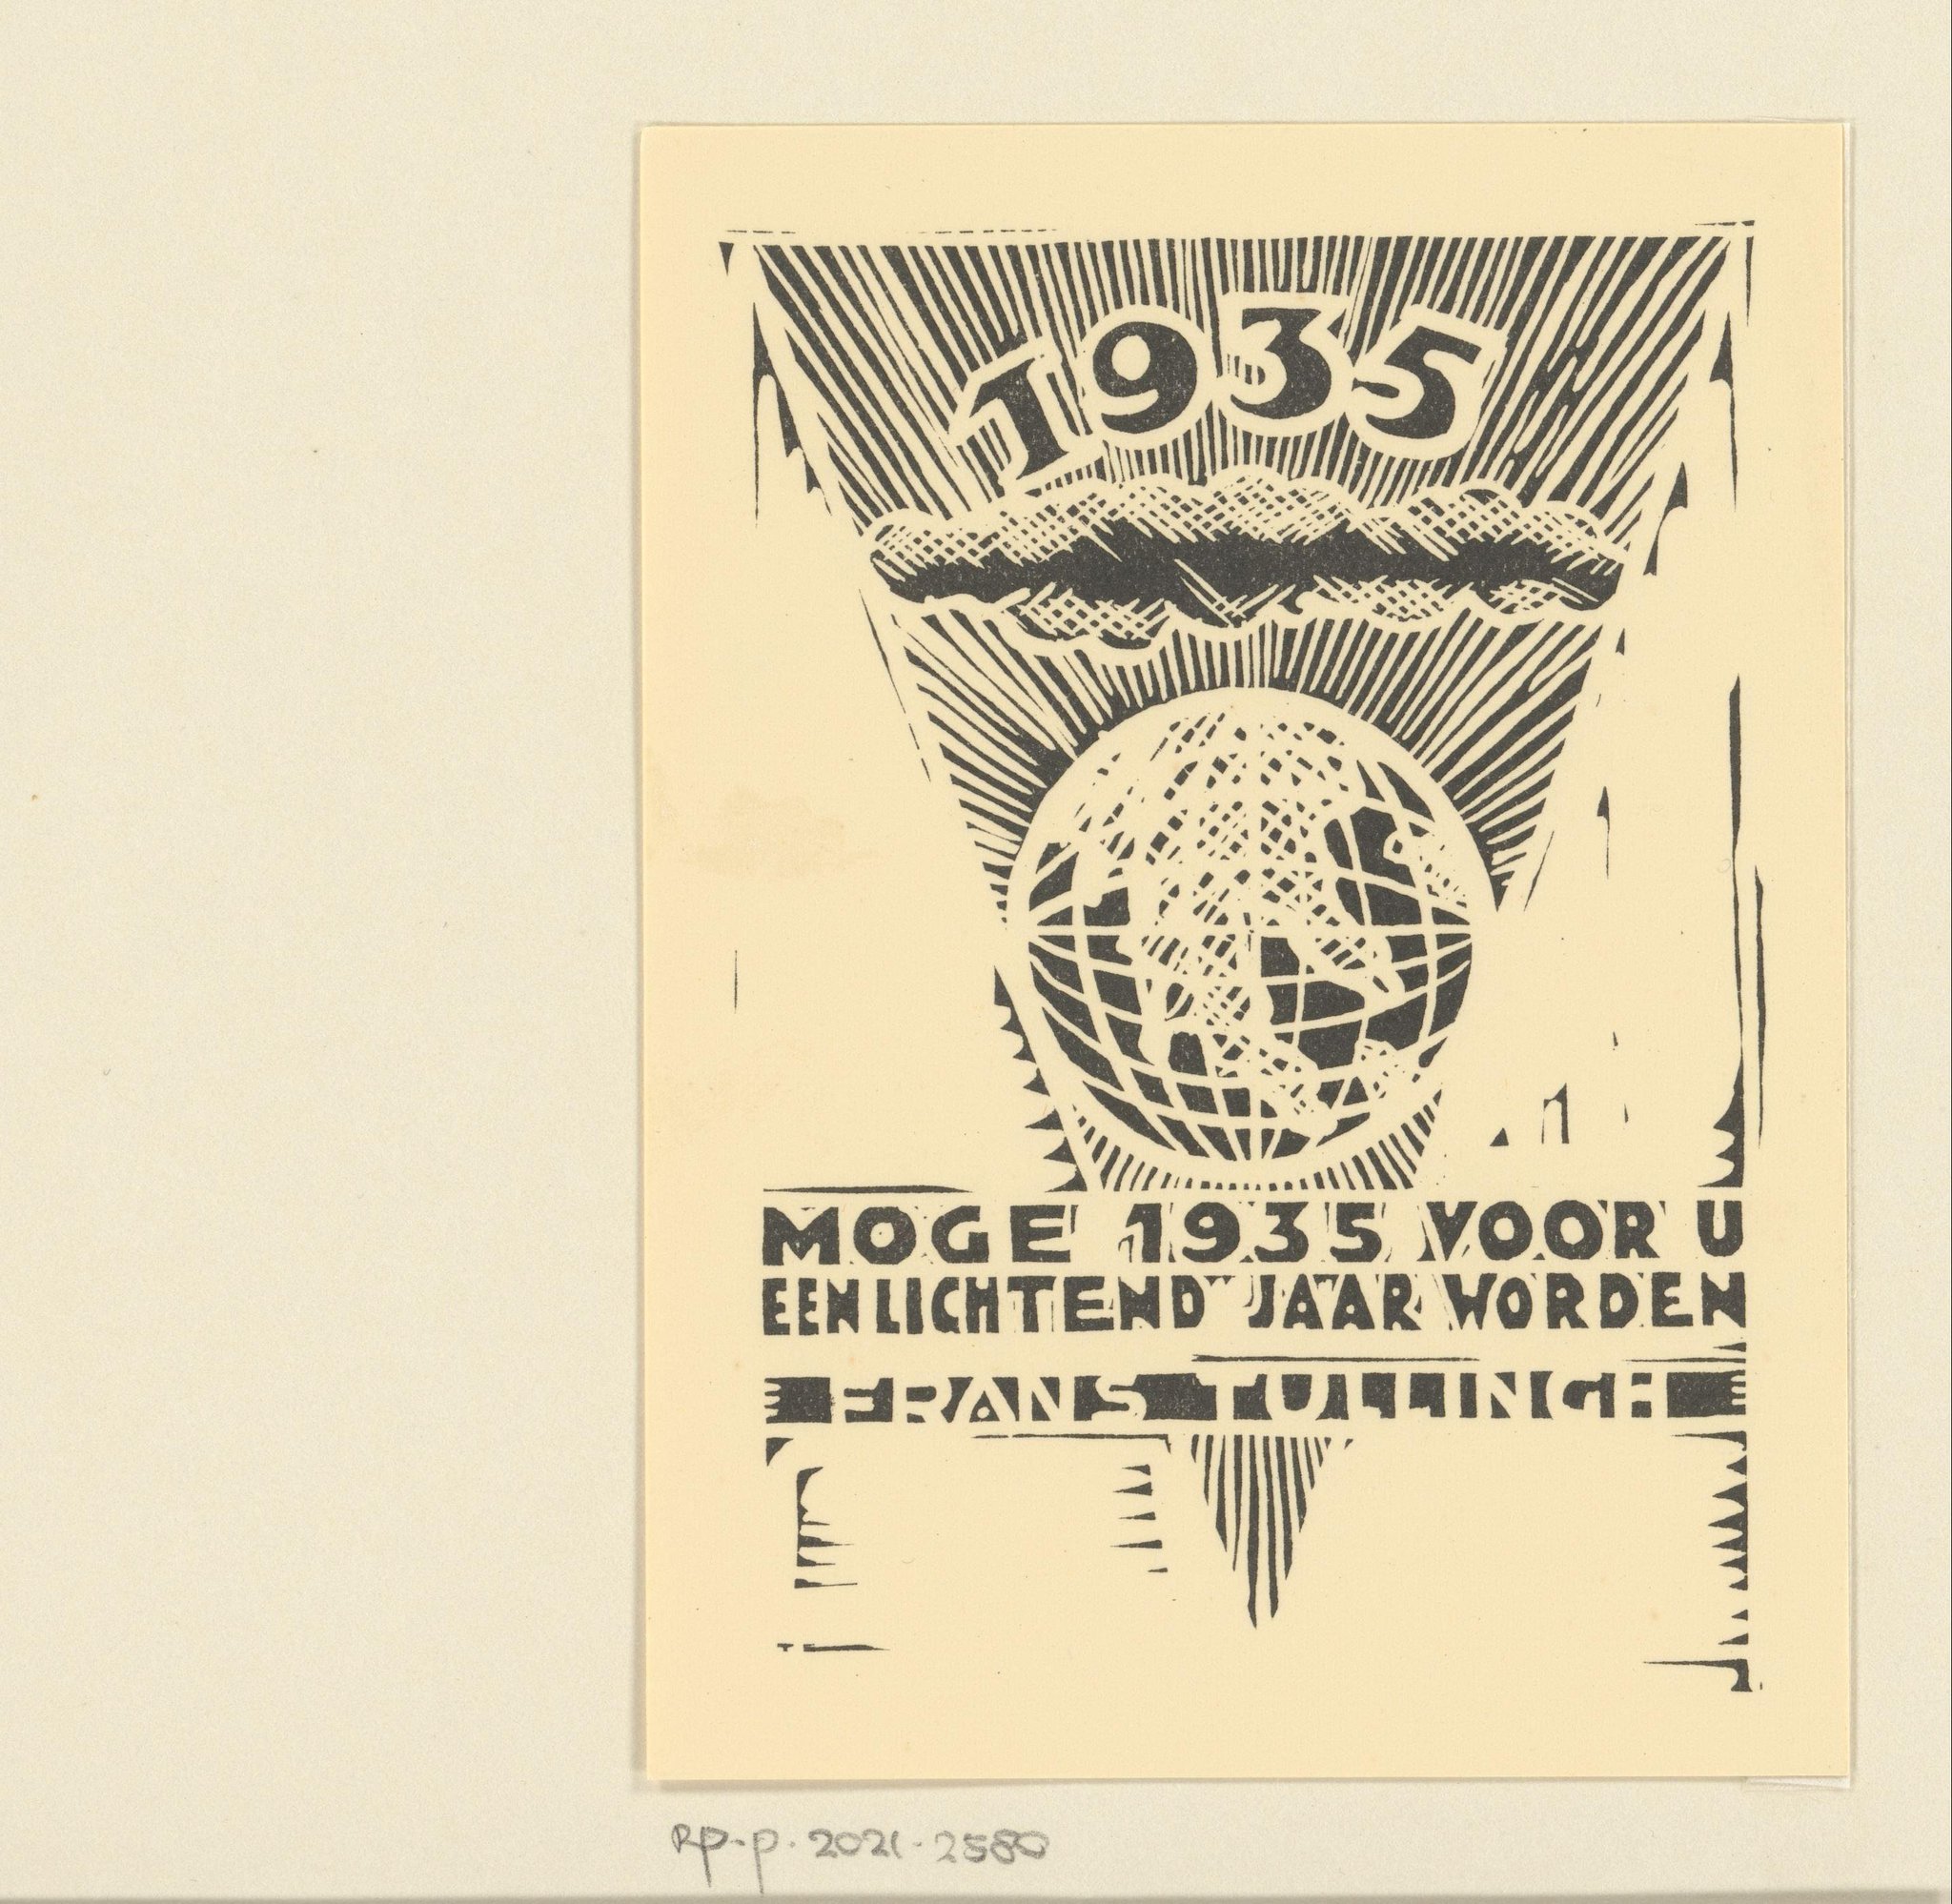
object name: new year card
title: Nieuwjaarswens voor 1935 van Frans Tullingh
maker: frans tullingh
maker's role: print maker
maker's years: 1876-1943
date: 1934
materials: paper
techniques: woodcut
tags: voorburg, print maker, frans tullingh, clouds, globe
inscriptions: date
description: Een globe met daarboven een wolk en daar weer boven het jaartal 1935. Met de tekst: 'Moge 1935 voor u een lichtend jaar worden'.